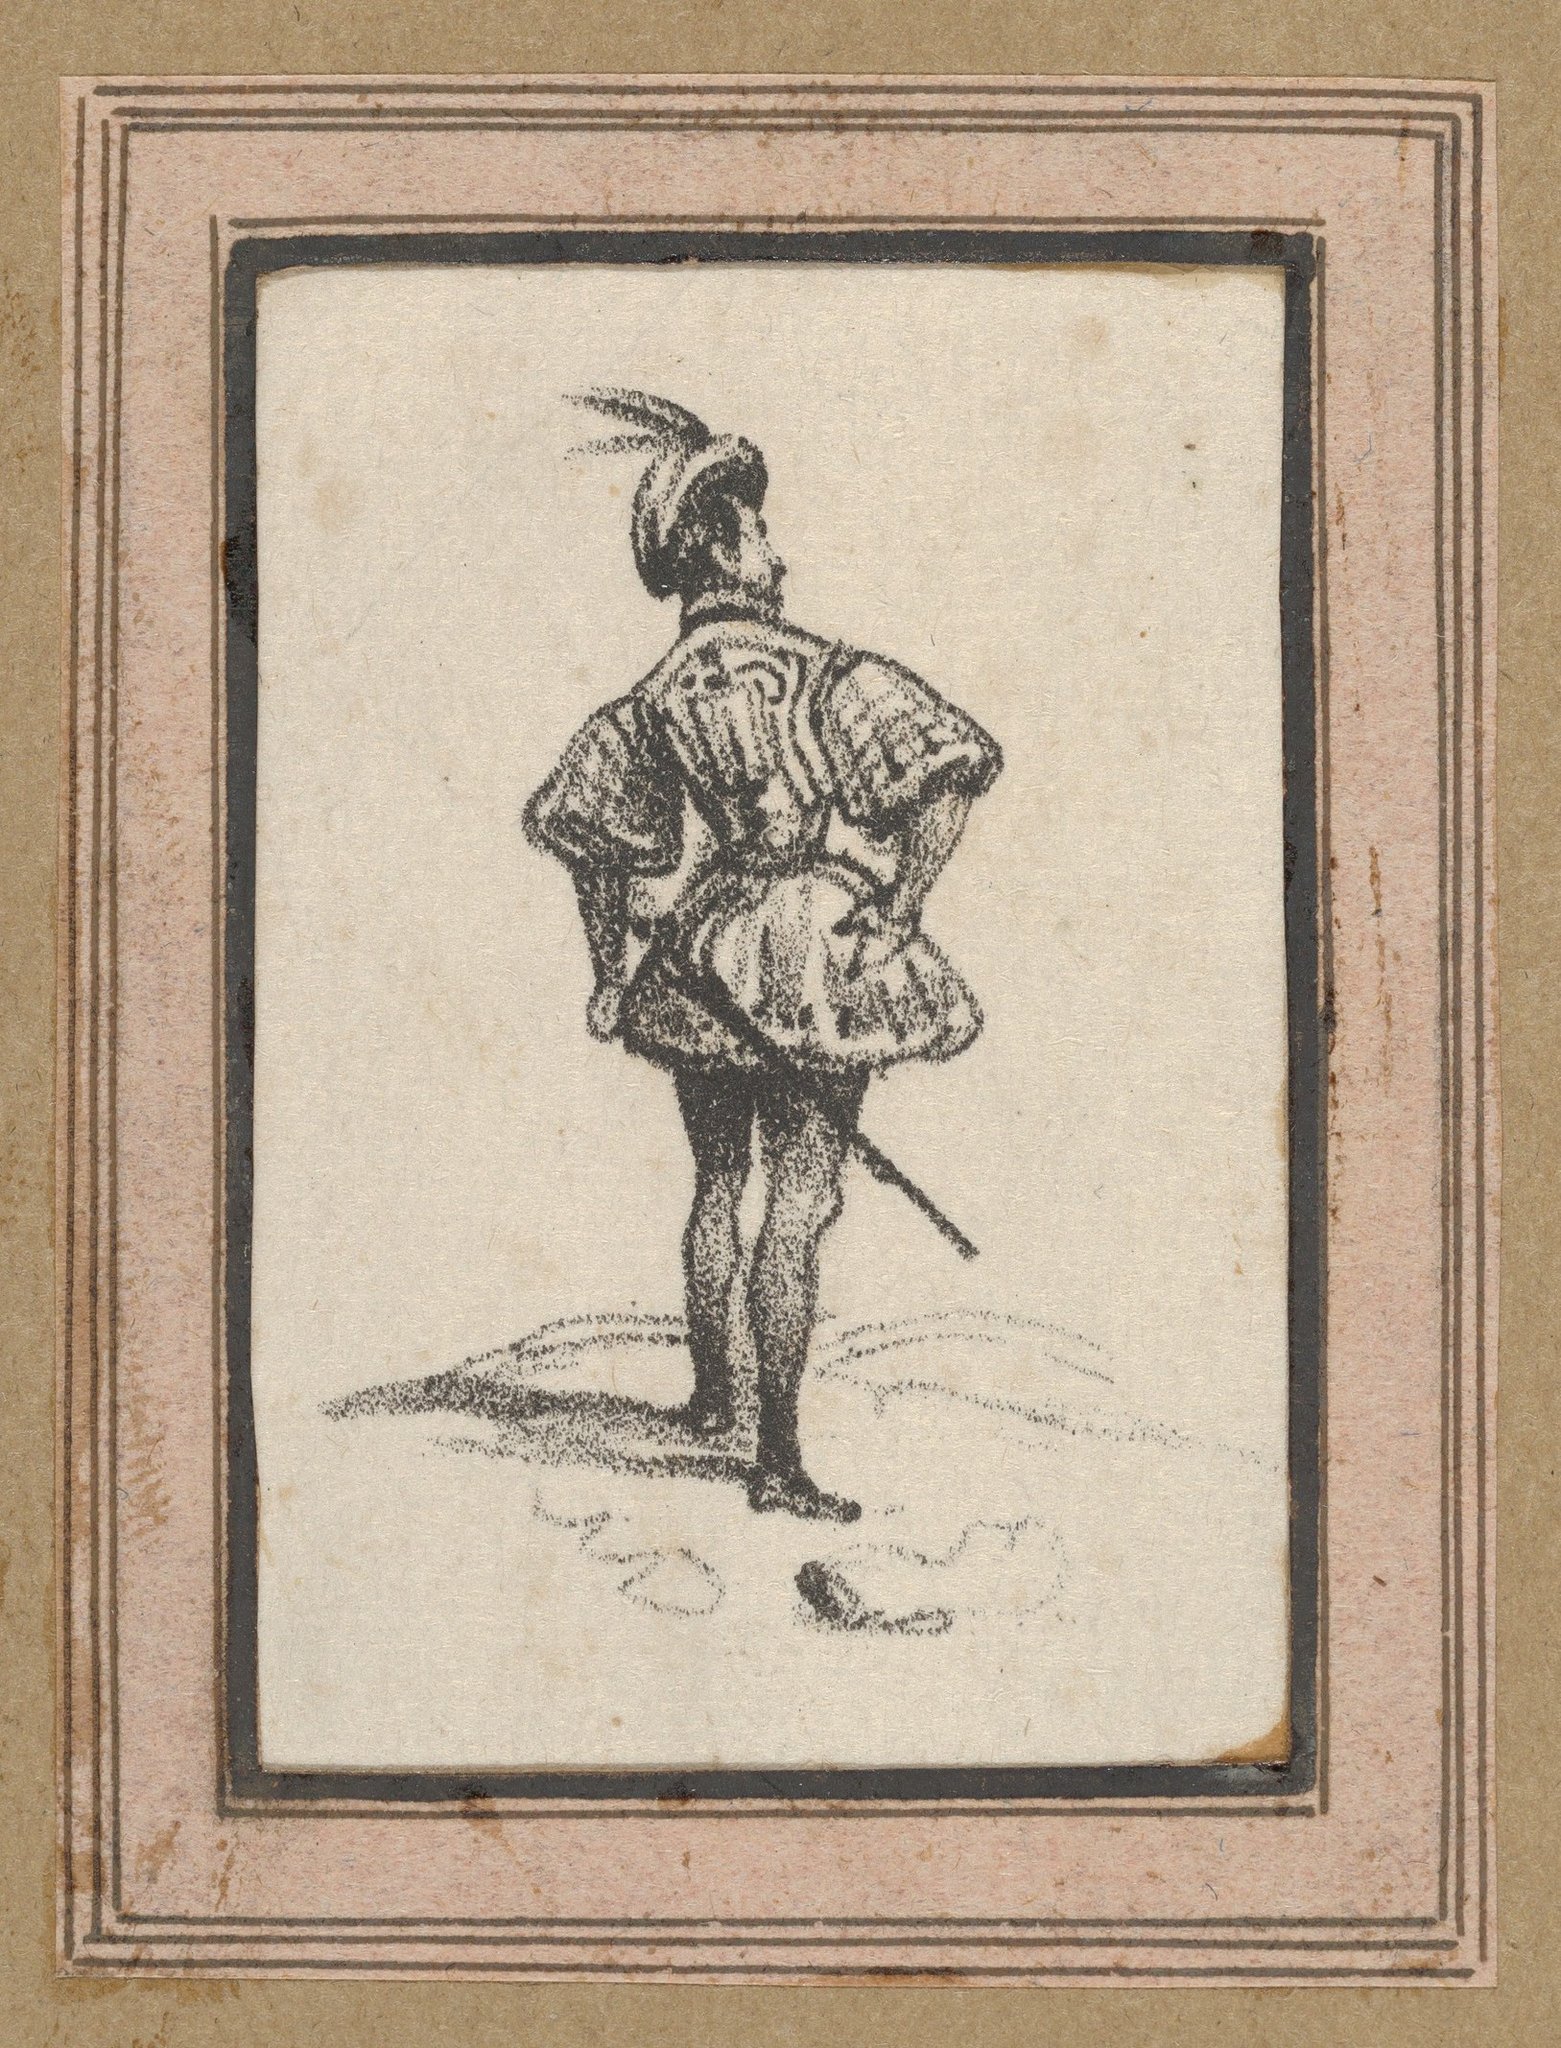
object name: print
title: Man with sword and feathered hat, viewed from the back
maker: victor adam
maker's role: artist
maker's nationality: french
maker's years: 1801-1866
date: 1834-1866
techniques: lithograph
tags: hats,swords,men